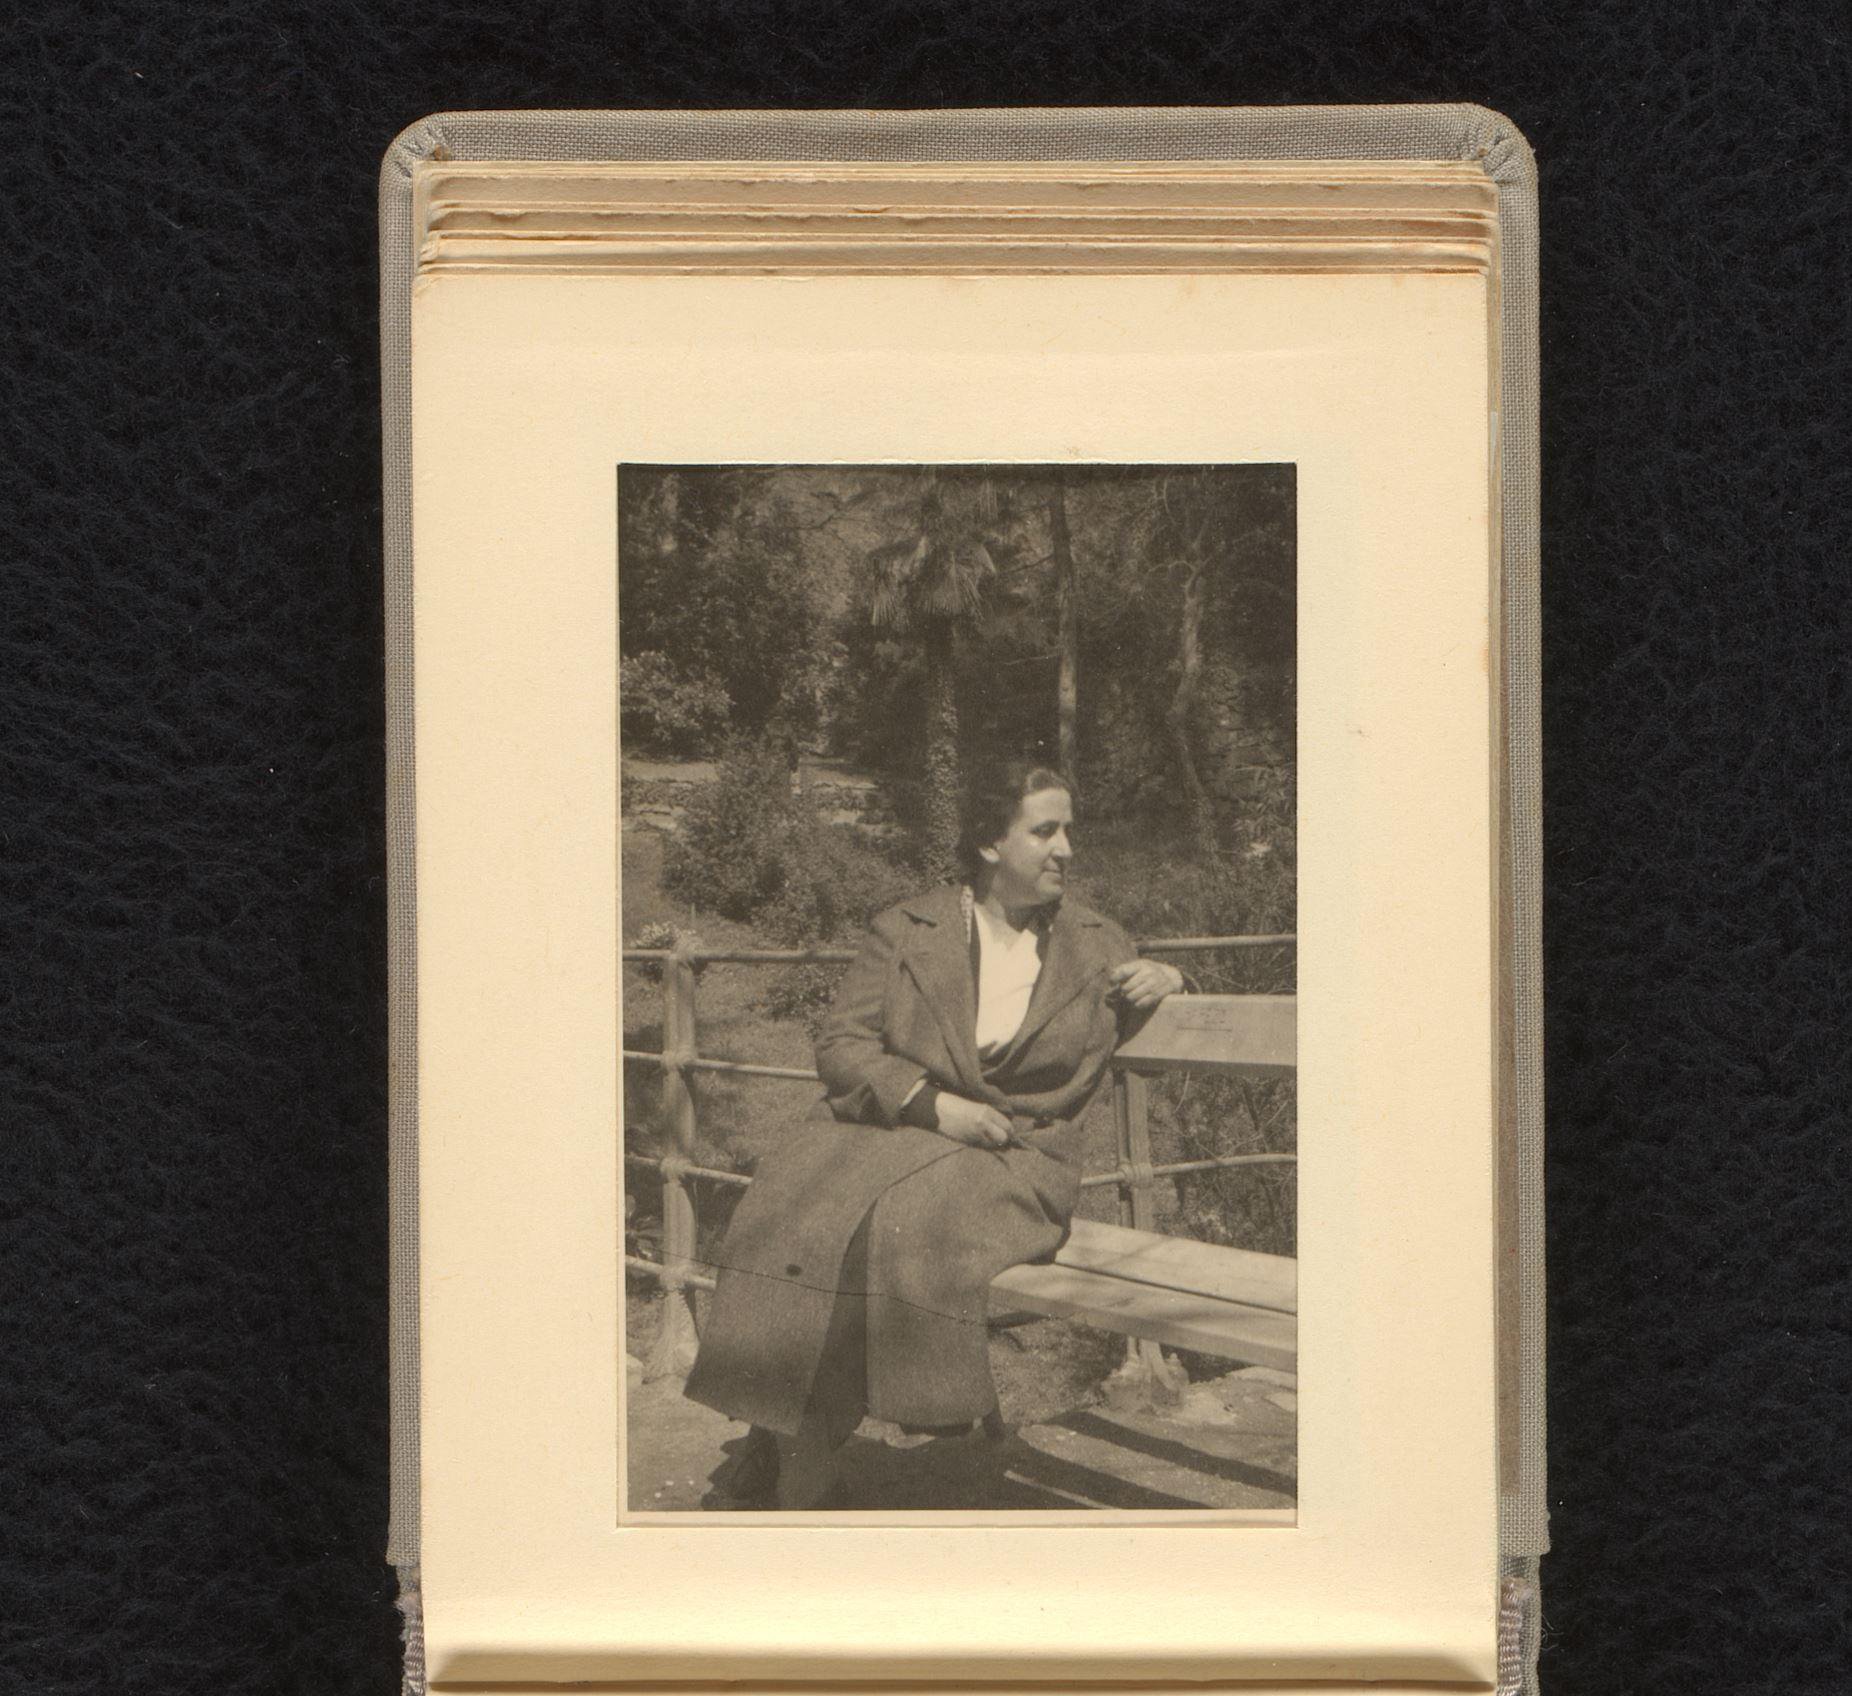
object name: photograph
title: Else Wachenheimer-Moos zit op een bankje in de openlucht, 1930-1940, Duitsland / Stuttgart / Hamburg / Zwitserland?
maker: isabel wachenheimer-elon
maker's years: 1928-2010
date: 1930-1940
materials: paper, photographic support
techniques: gelatin silver print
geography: germany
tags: else wachenheimer-moos, the family travelling, on holiday, historical persons - bb - woman, germany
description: Albumblad bevat een foto van Else Wachenheimer-Moos. Onderdeel van het fotoalbum met diverse foto's van de jeugd van Isabel Wachenheimer voor en tijdens de oorlog en diverse momenten van haar volwassen leven na de Tweede Wereldoorlog.